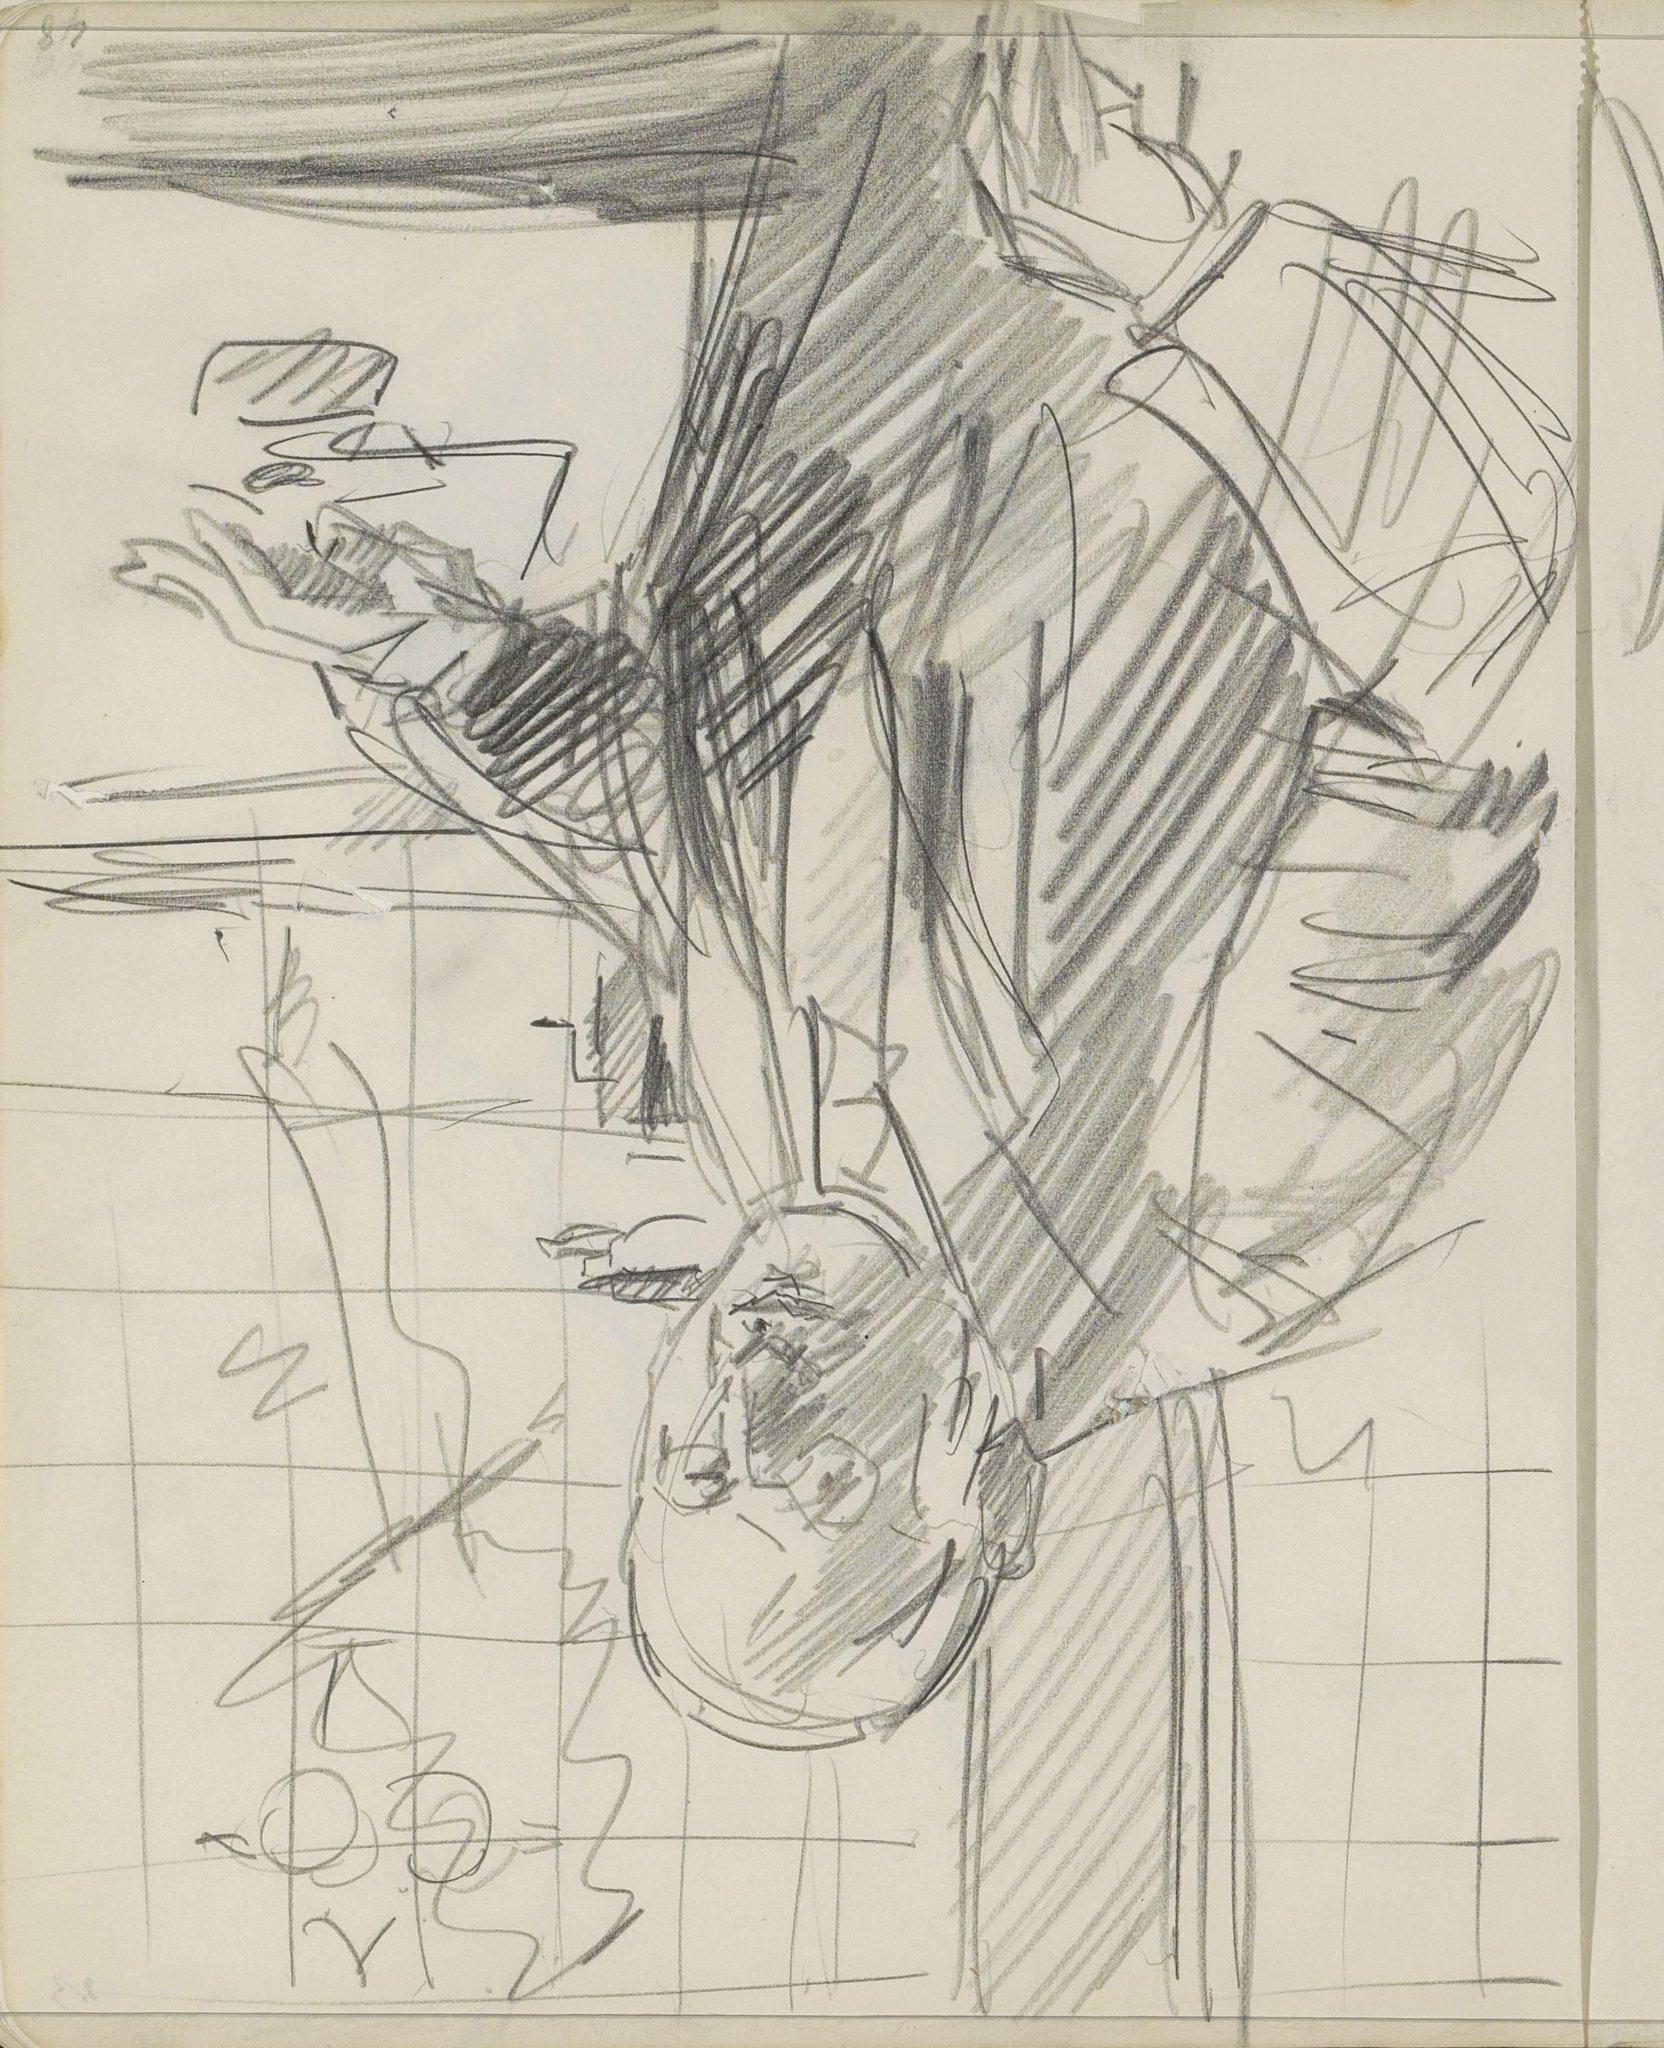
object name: sketchbook leaf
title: Man aan een tafel in een interieur, mogelijk Nehemia de Lieme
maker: isaac israels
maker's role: draughtsman, painter, print maker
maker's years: 1865-1934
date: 1925-1934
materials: paper, pencil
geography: the hague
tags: writing-table, writing-desk, historical persons, interior of the house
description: Achter hem ramen. Blad 23 verso en blad 24 recto uit schetsboek XXVI met 35 bladen.